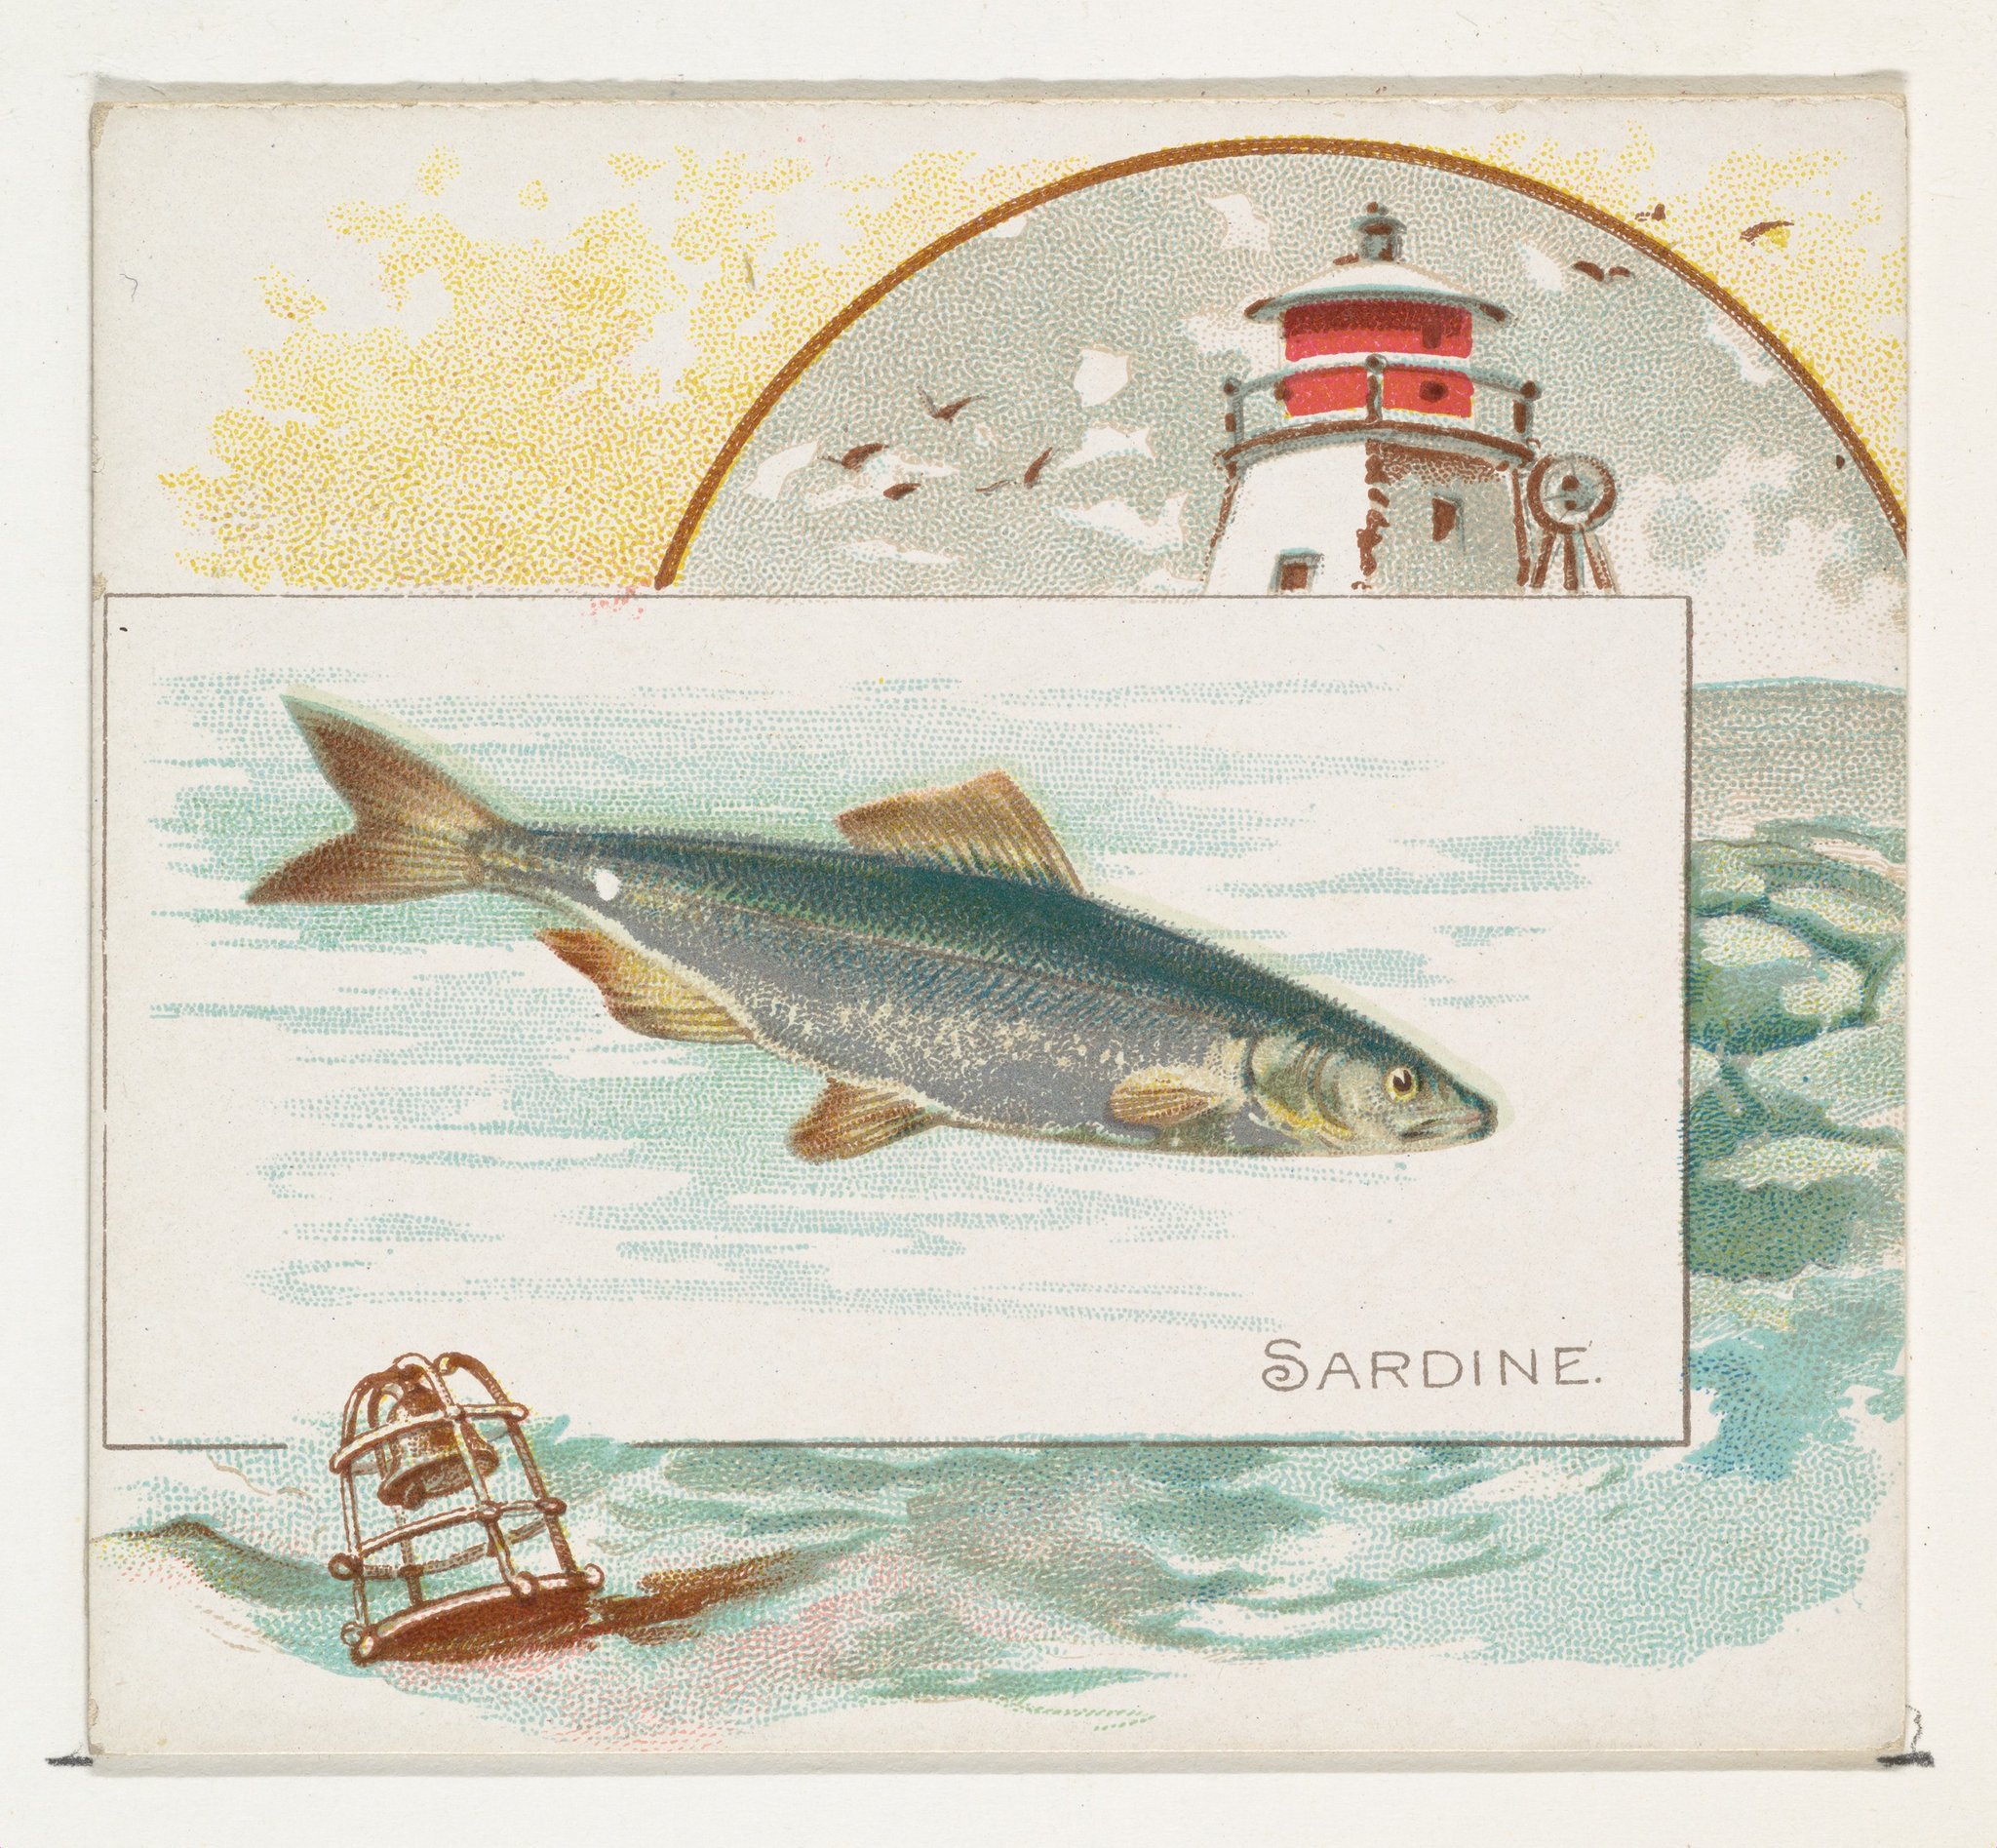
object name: print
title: Sardine, from Fish from American Waters series (N39) for Allen & Ginter Cigarettes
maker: allen & ginter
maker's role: publisher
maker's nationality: american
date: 1889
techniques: color lithograph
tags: fish